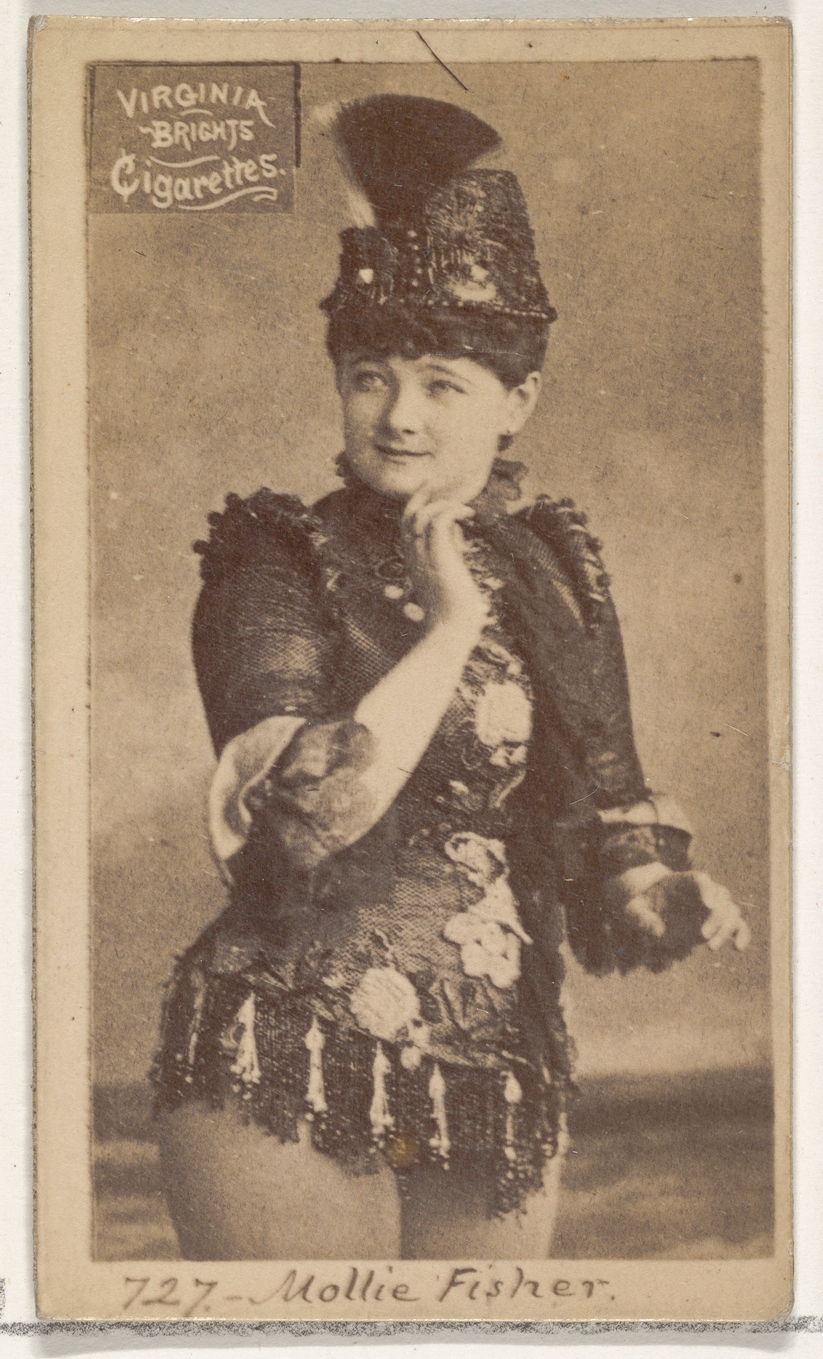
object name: photograph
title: Card 727, Mollie Fisher, from the Actors and Actresses series (N45, Type 2) for Virginia Brights Cigarettes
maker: allen & ginter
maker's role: publisher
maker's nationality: american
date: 1888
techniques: albumen silver print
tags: portraits,women,actresses